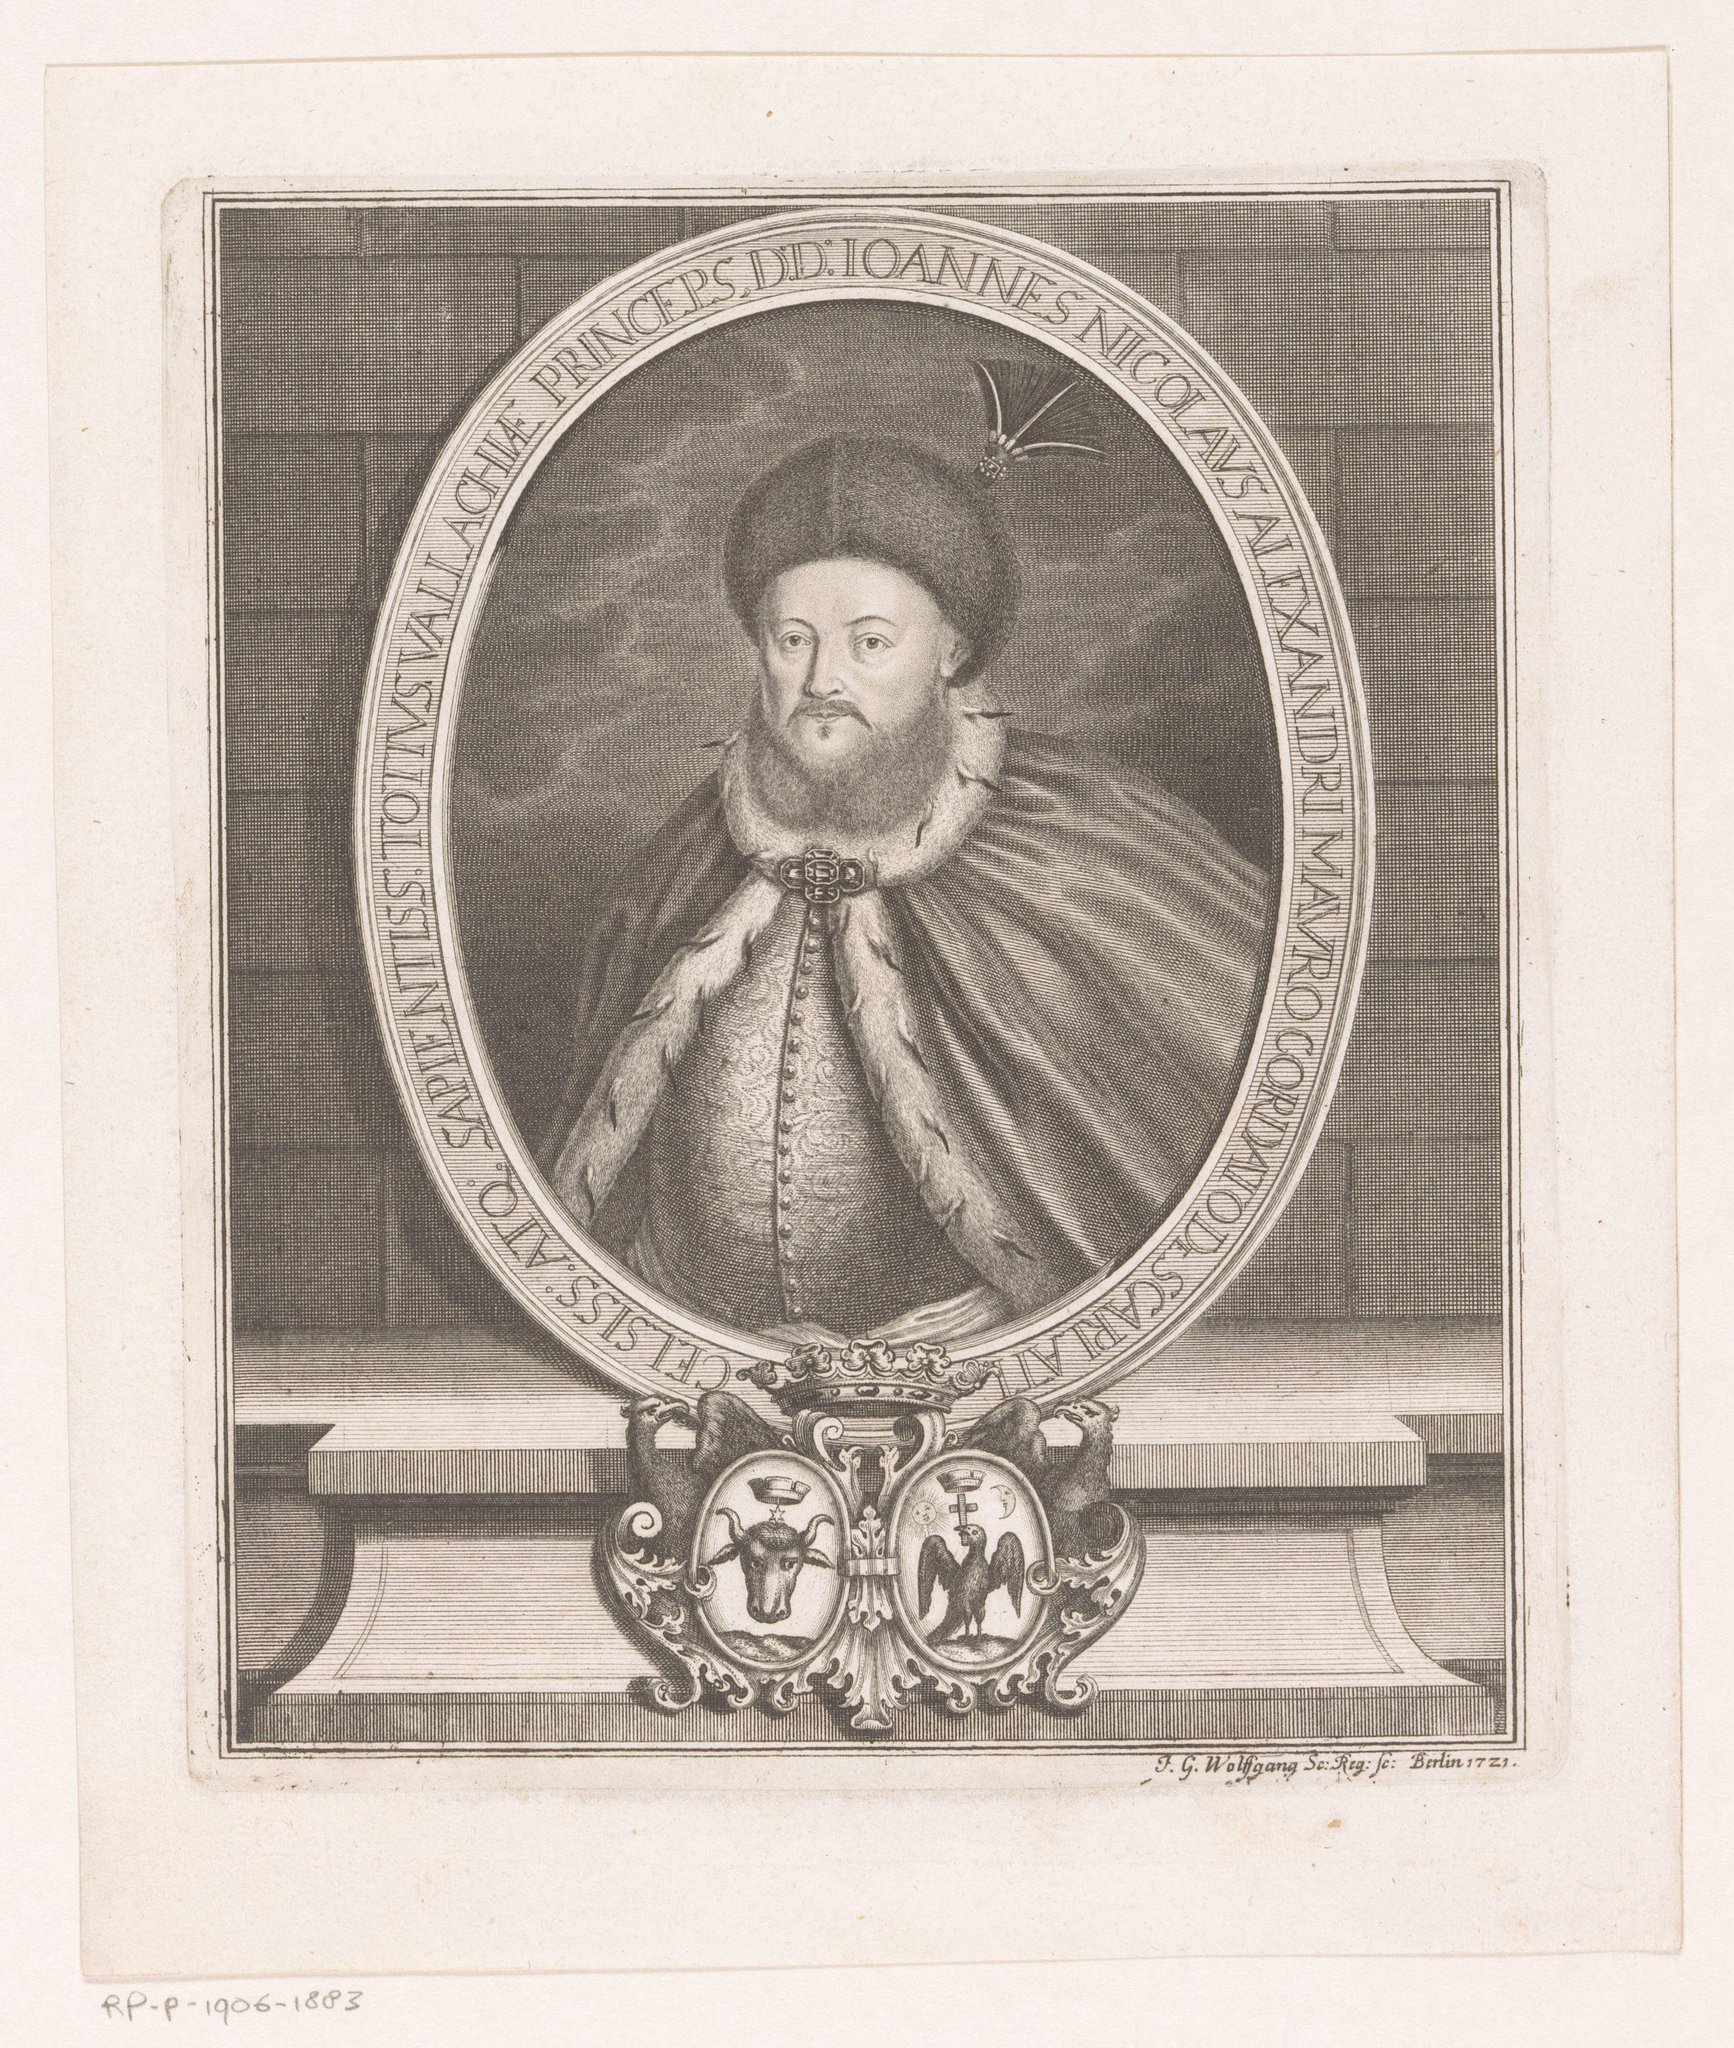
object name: print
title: Portret van Nikolaos Maurokordatos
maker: johann georg wolfgang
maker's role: graveur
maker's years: 1662-1744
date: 1721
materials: paper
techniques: engraving, etching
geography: berlin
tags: historical persons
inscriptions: collector's mark: Lugt 2228